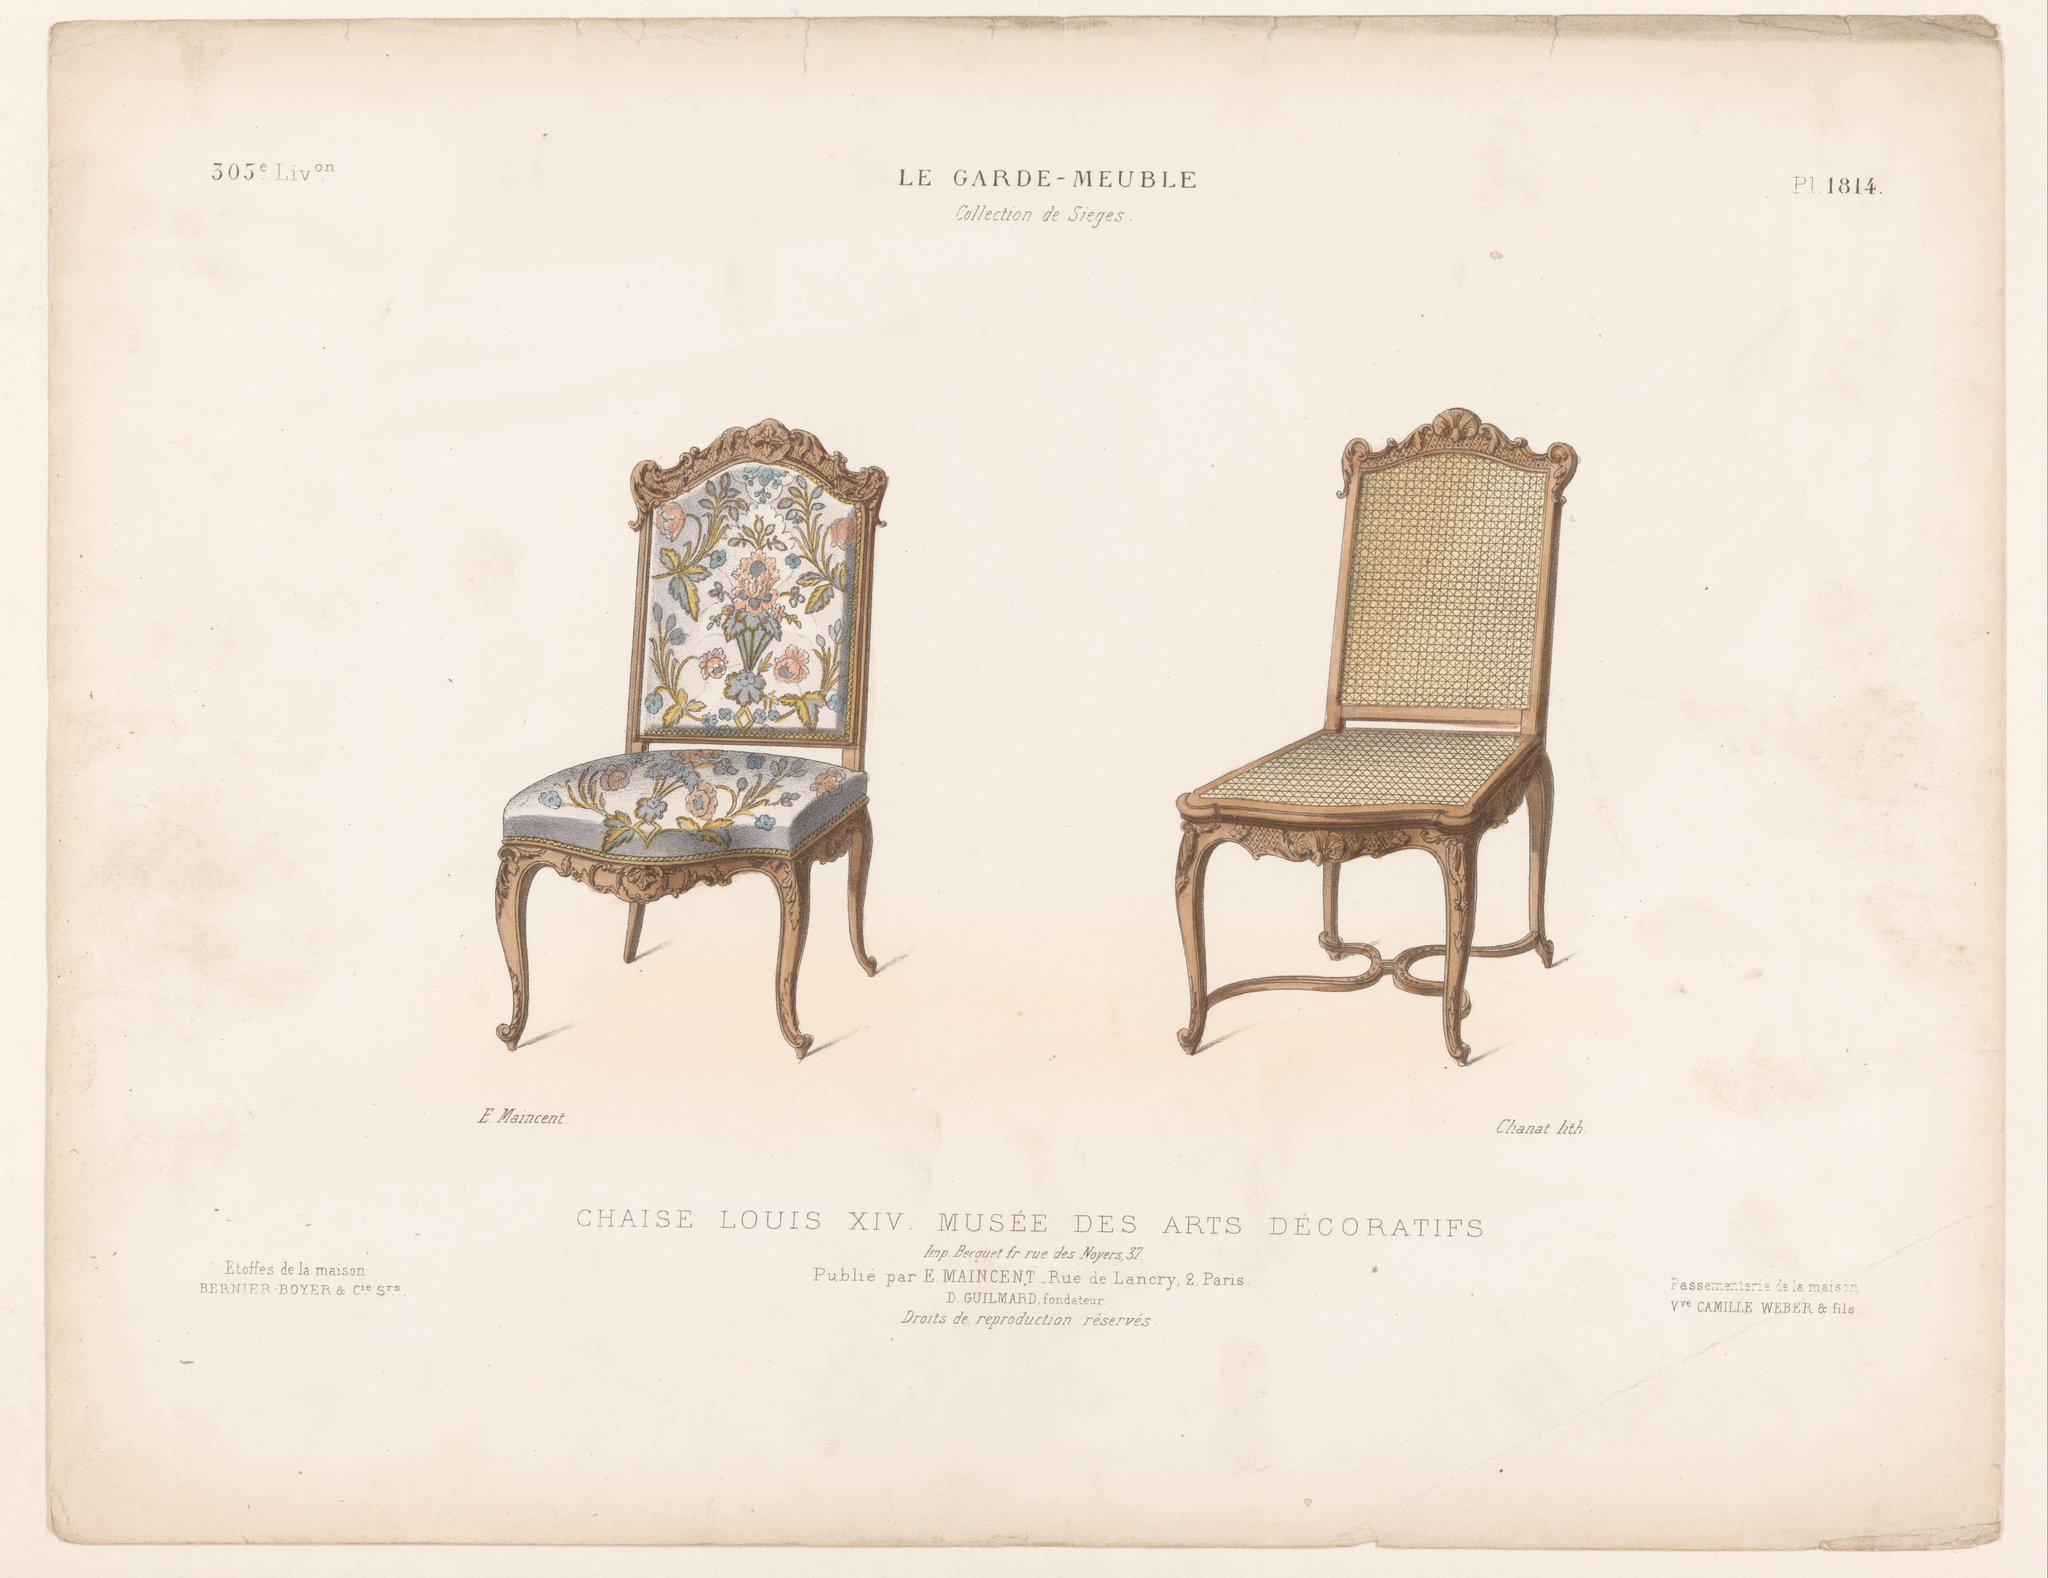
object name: print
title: Twee stoelen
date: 1885-1895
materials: paper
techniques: hand coloring, lithograph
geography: paris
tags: seating furniture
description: Ieder Livraison in de serie Le Garde-Meuble bevat negen platen: drie 'sièges' (zitmeubels), drie 'meubles' (diverse meubels zoals tafels en kasten) en drie 'tentures' (gordijnen en draperieën).